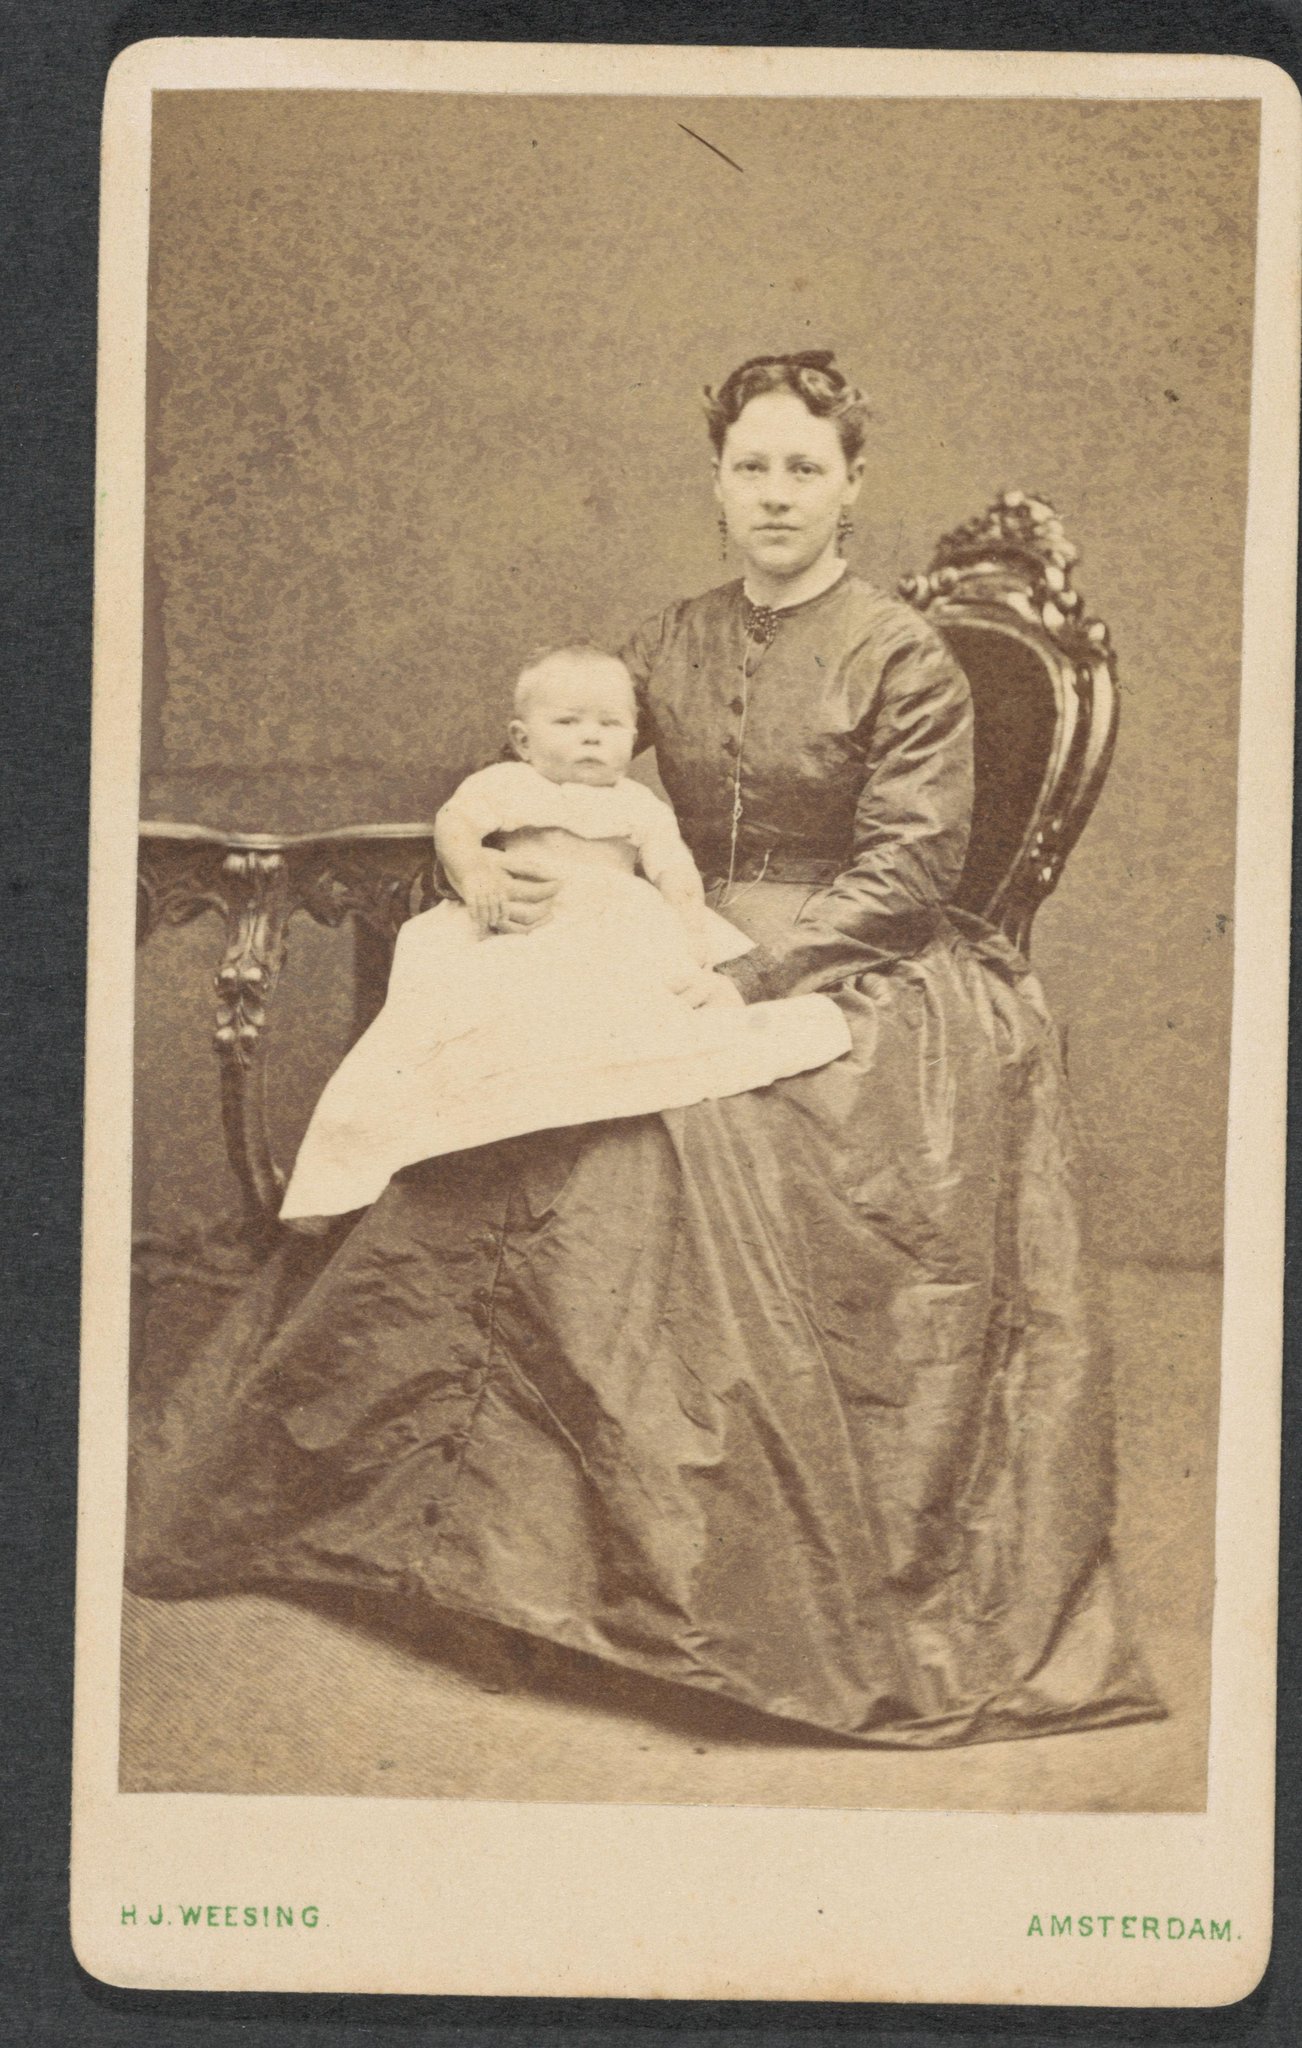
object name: carte de visite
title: Portret van een onbekende vrouw uit de familie Marmelstein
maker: hermanus jodocus weesing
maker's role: fotograaf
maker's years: 1844-1910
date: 1850-1900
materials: cardboard, photographic support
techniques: albumen print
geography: amsterdam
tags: adult woman, child, historical persons